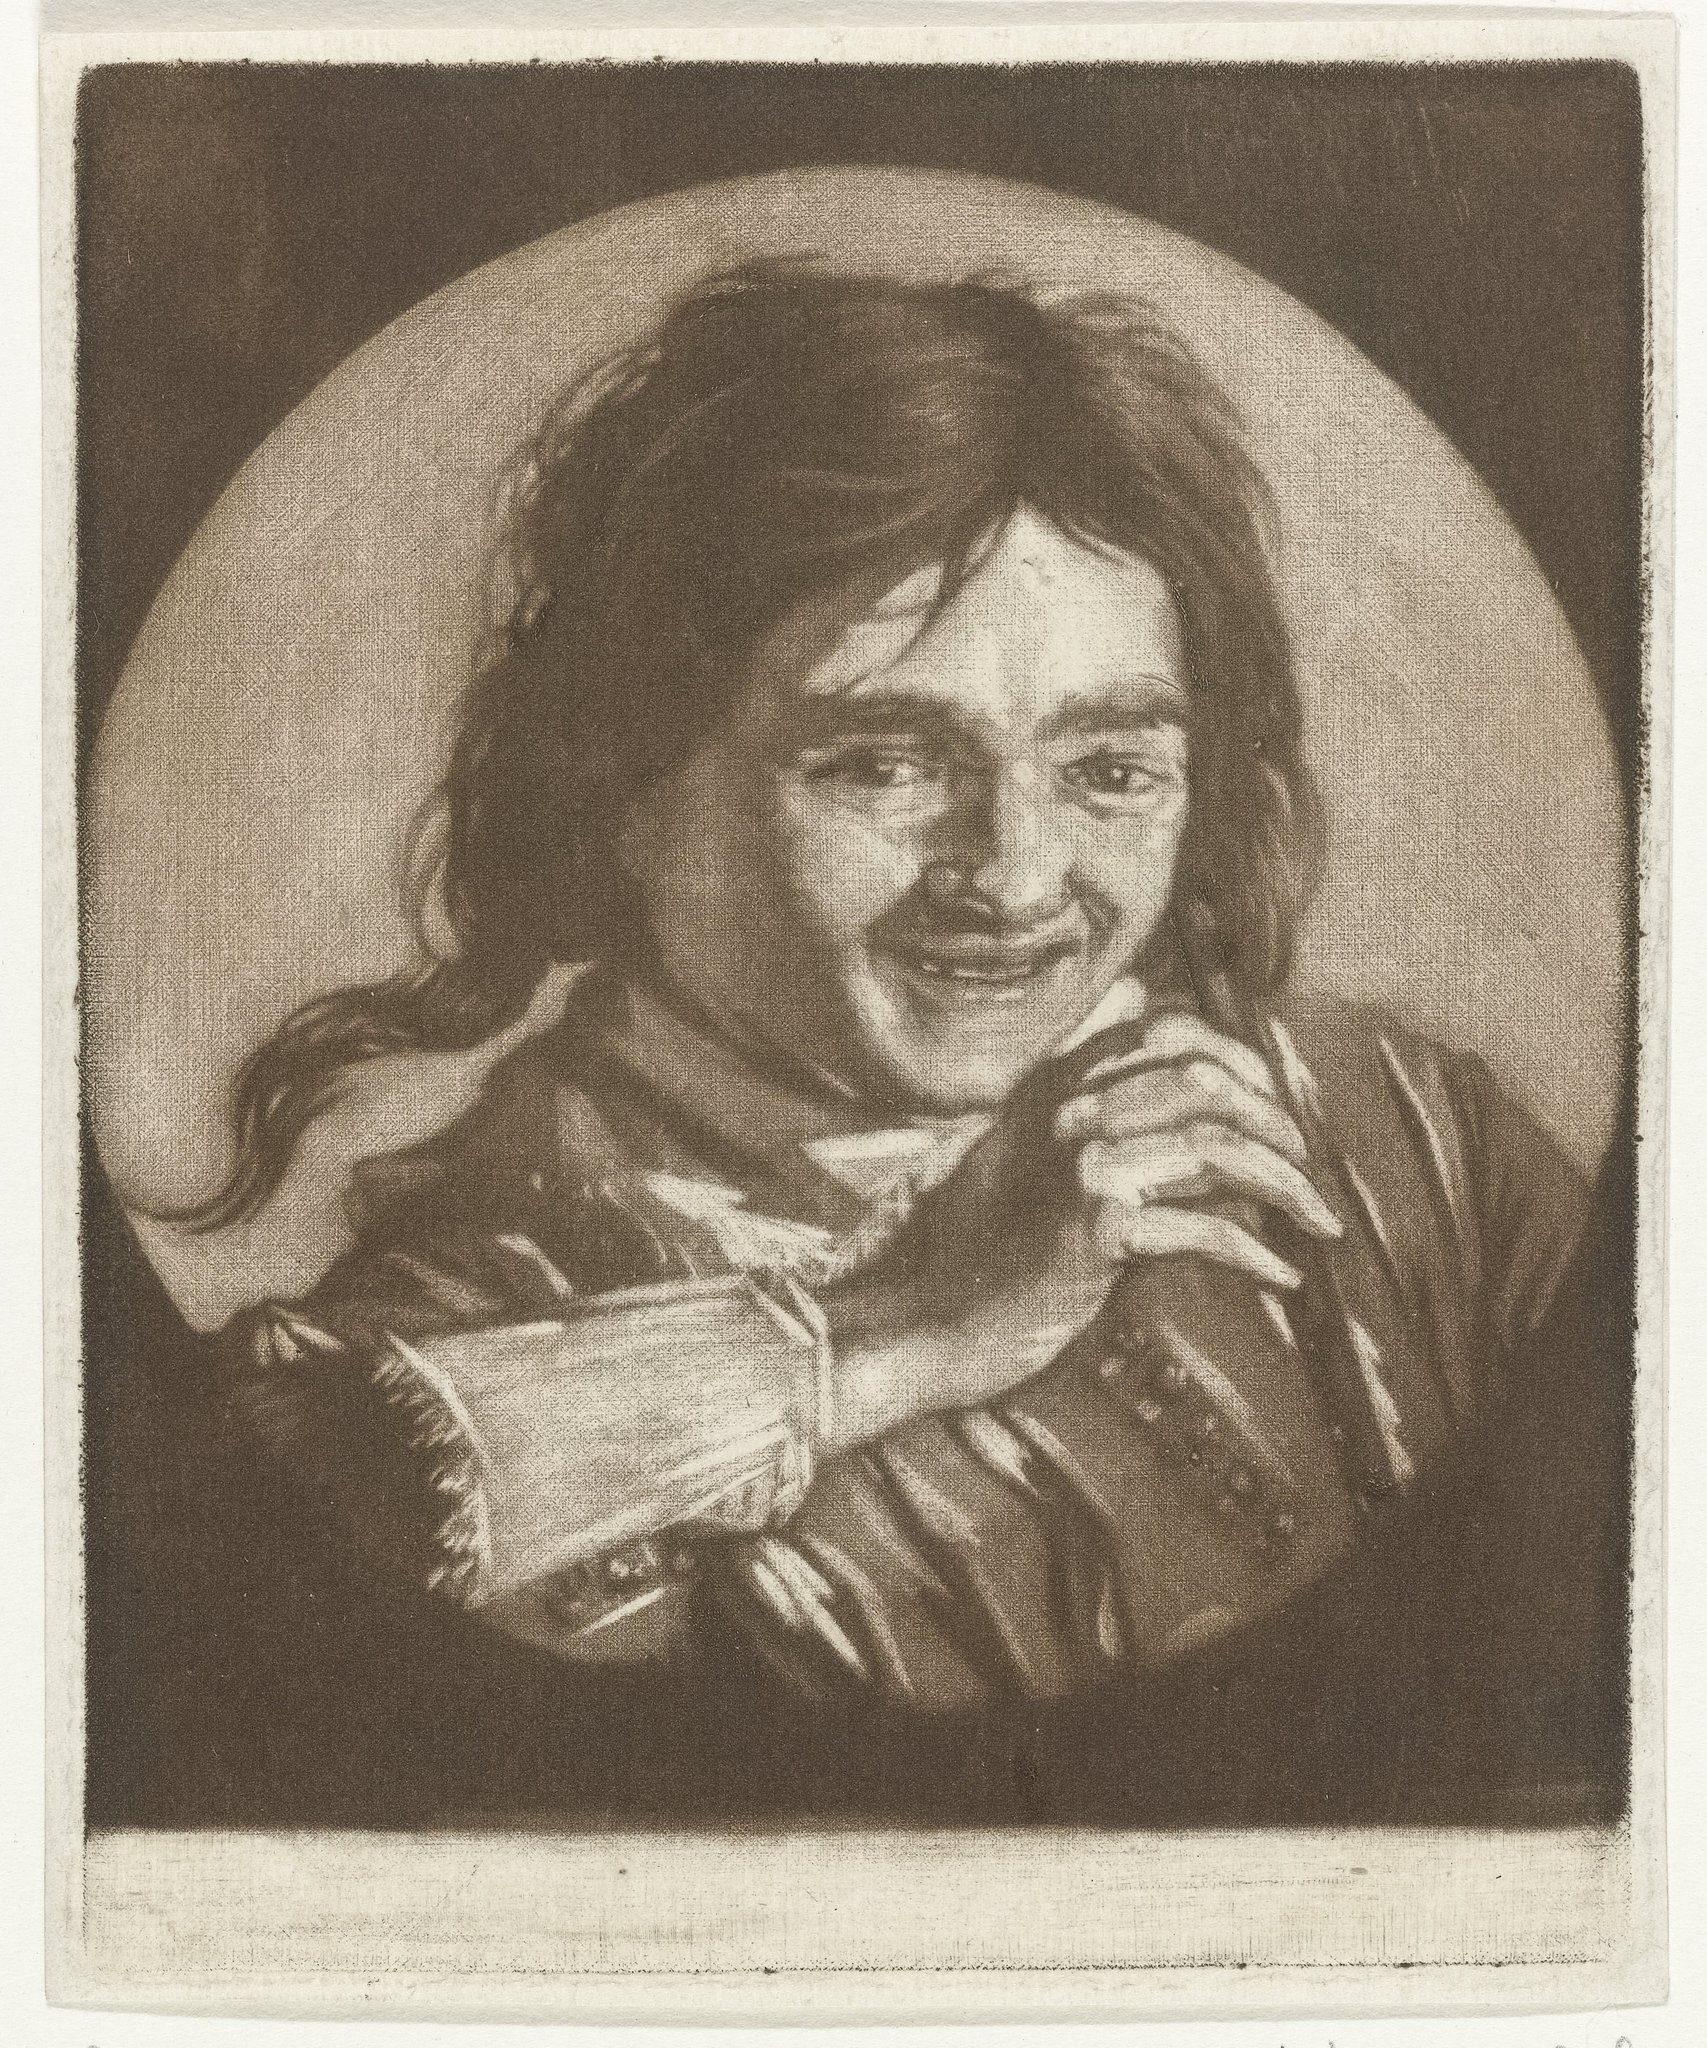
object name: print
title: Man met een fluit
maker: frans hals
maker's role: draughtsman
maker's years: 1582-1666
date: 1683-1755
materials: paper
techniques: mezzotint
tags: one person playing wind instrument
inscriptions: collector's mark: Lugt 240